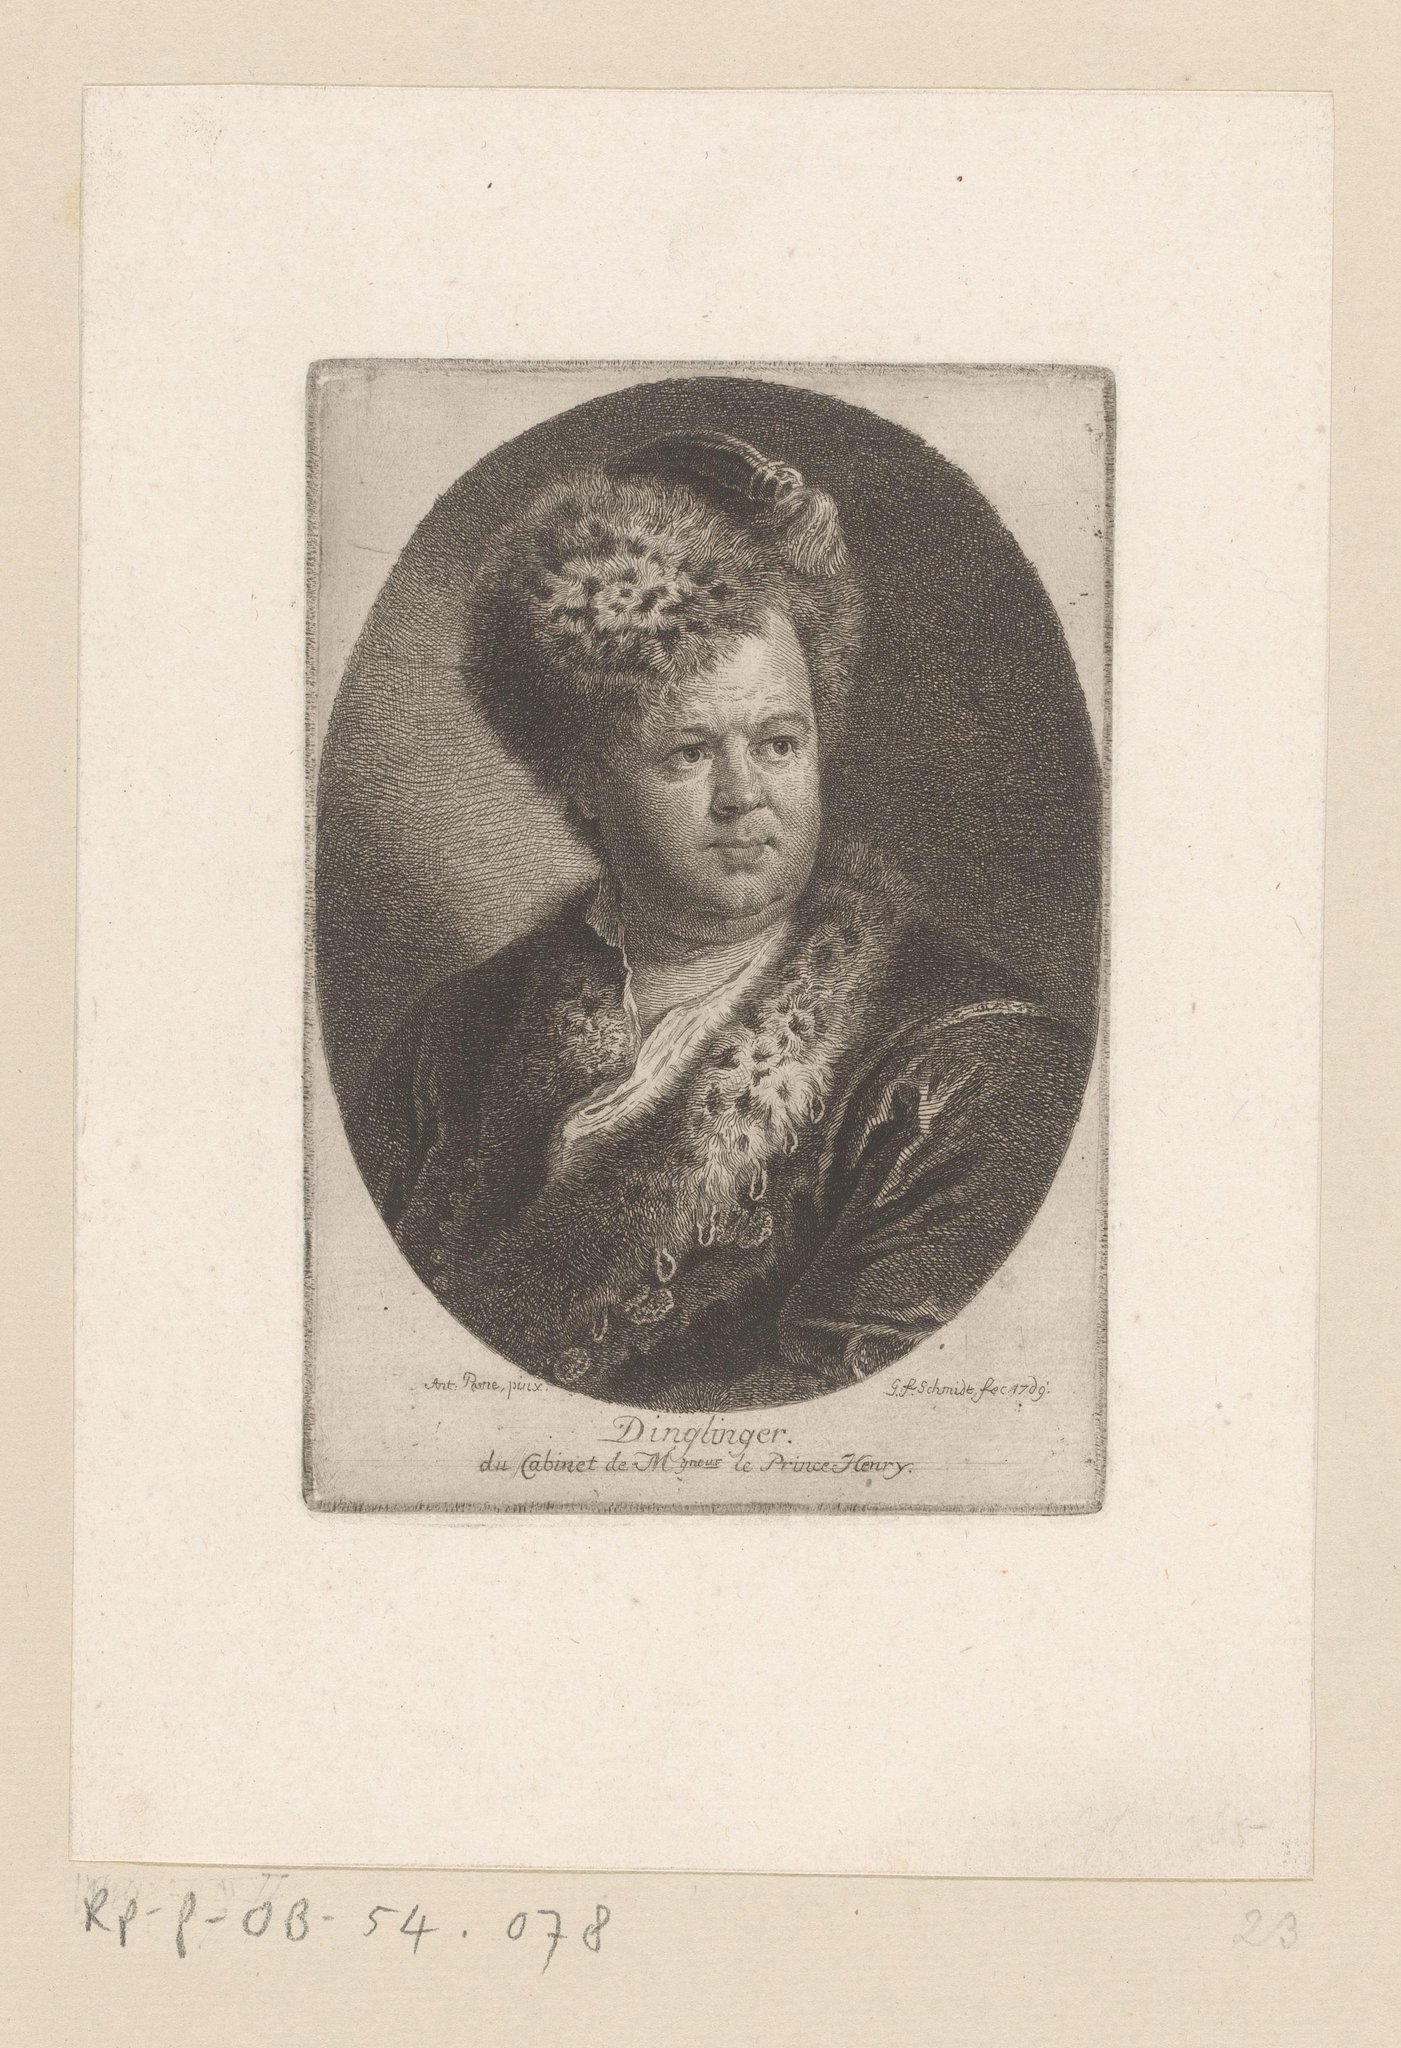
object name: print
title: Portret van Johann Melchior Dinglinger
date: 1769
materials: paper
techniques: etching, intaglio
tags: goldsmith, johann melchior dinglinger, historical persons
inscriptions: collector's mark: Lugt 240